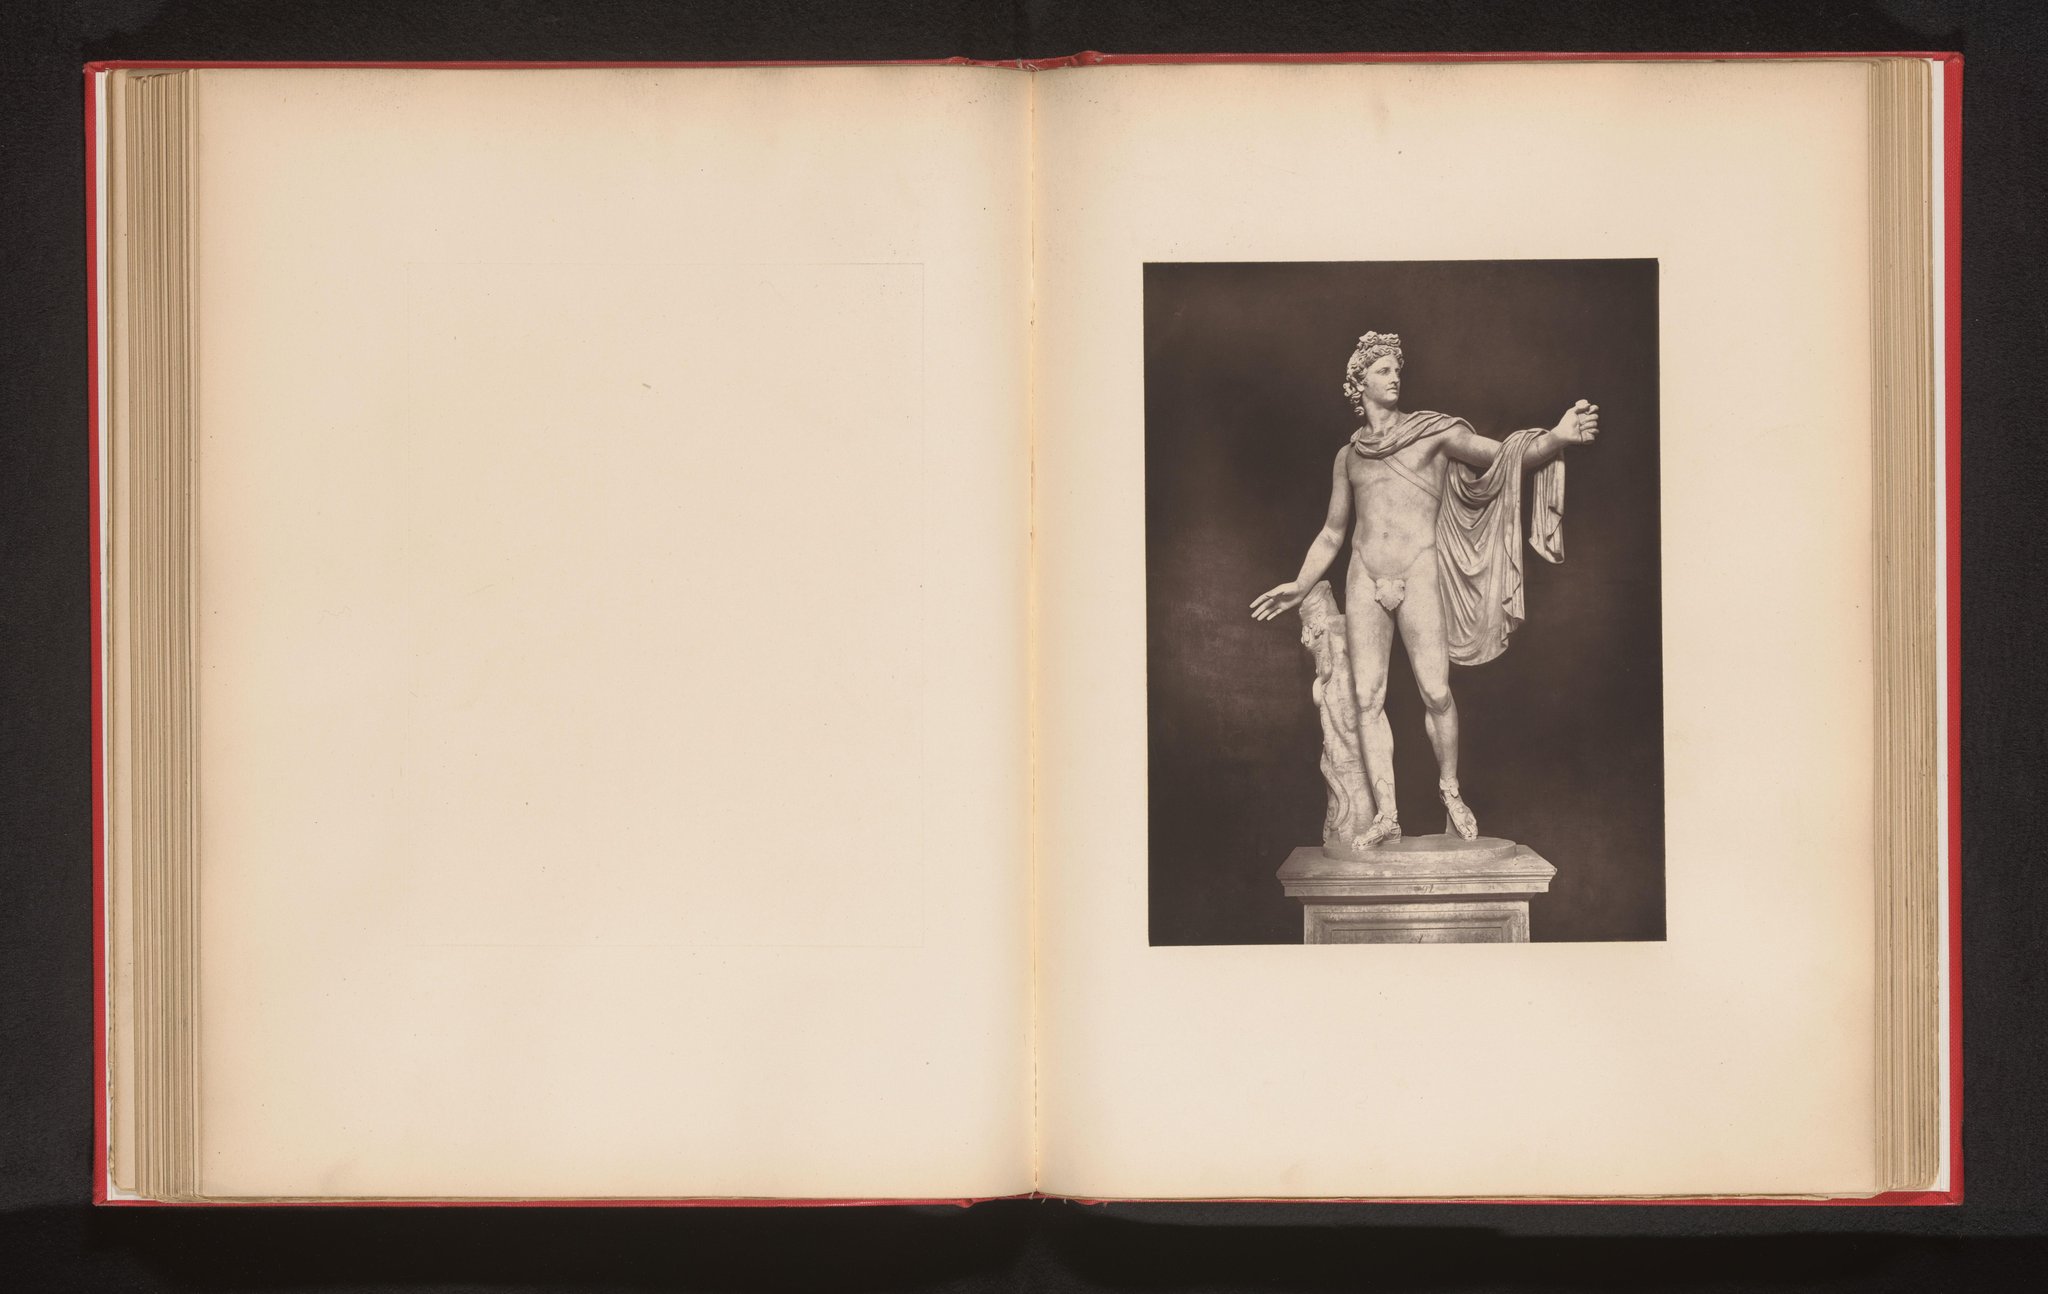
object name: page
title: Apollo van Belvedère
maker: stephen thompson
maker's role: fotograaf, schrijver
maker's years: 1831-1893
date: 1873-1878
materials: paper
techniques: woodburytype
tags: sculpture